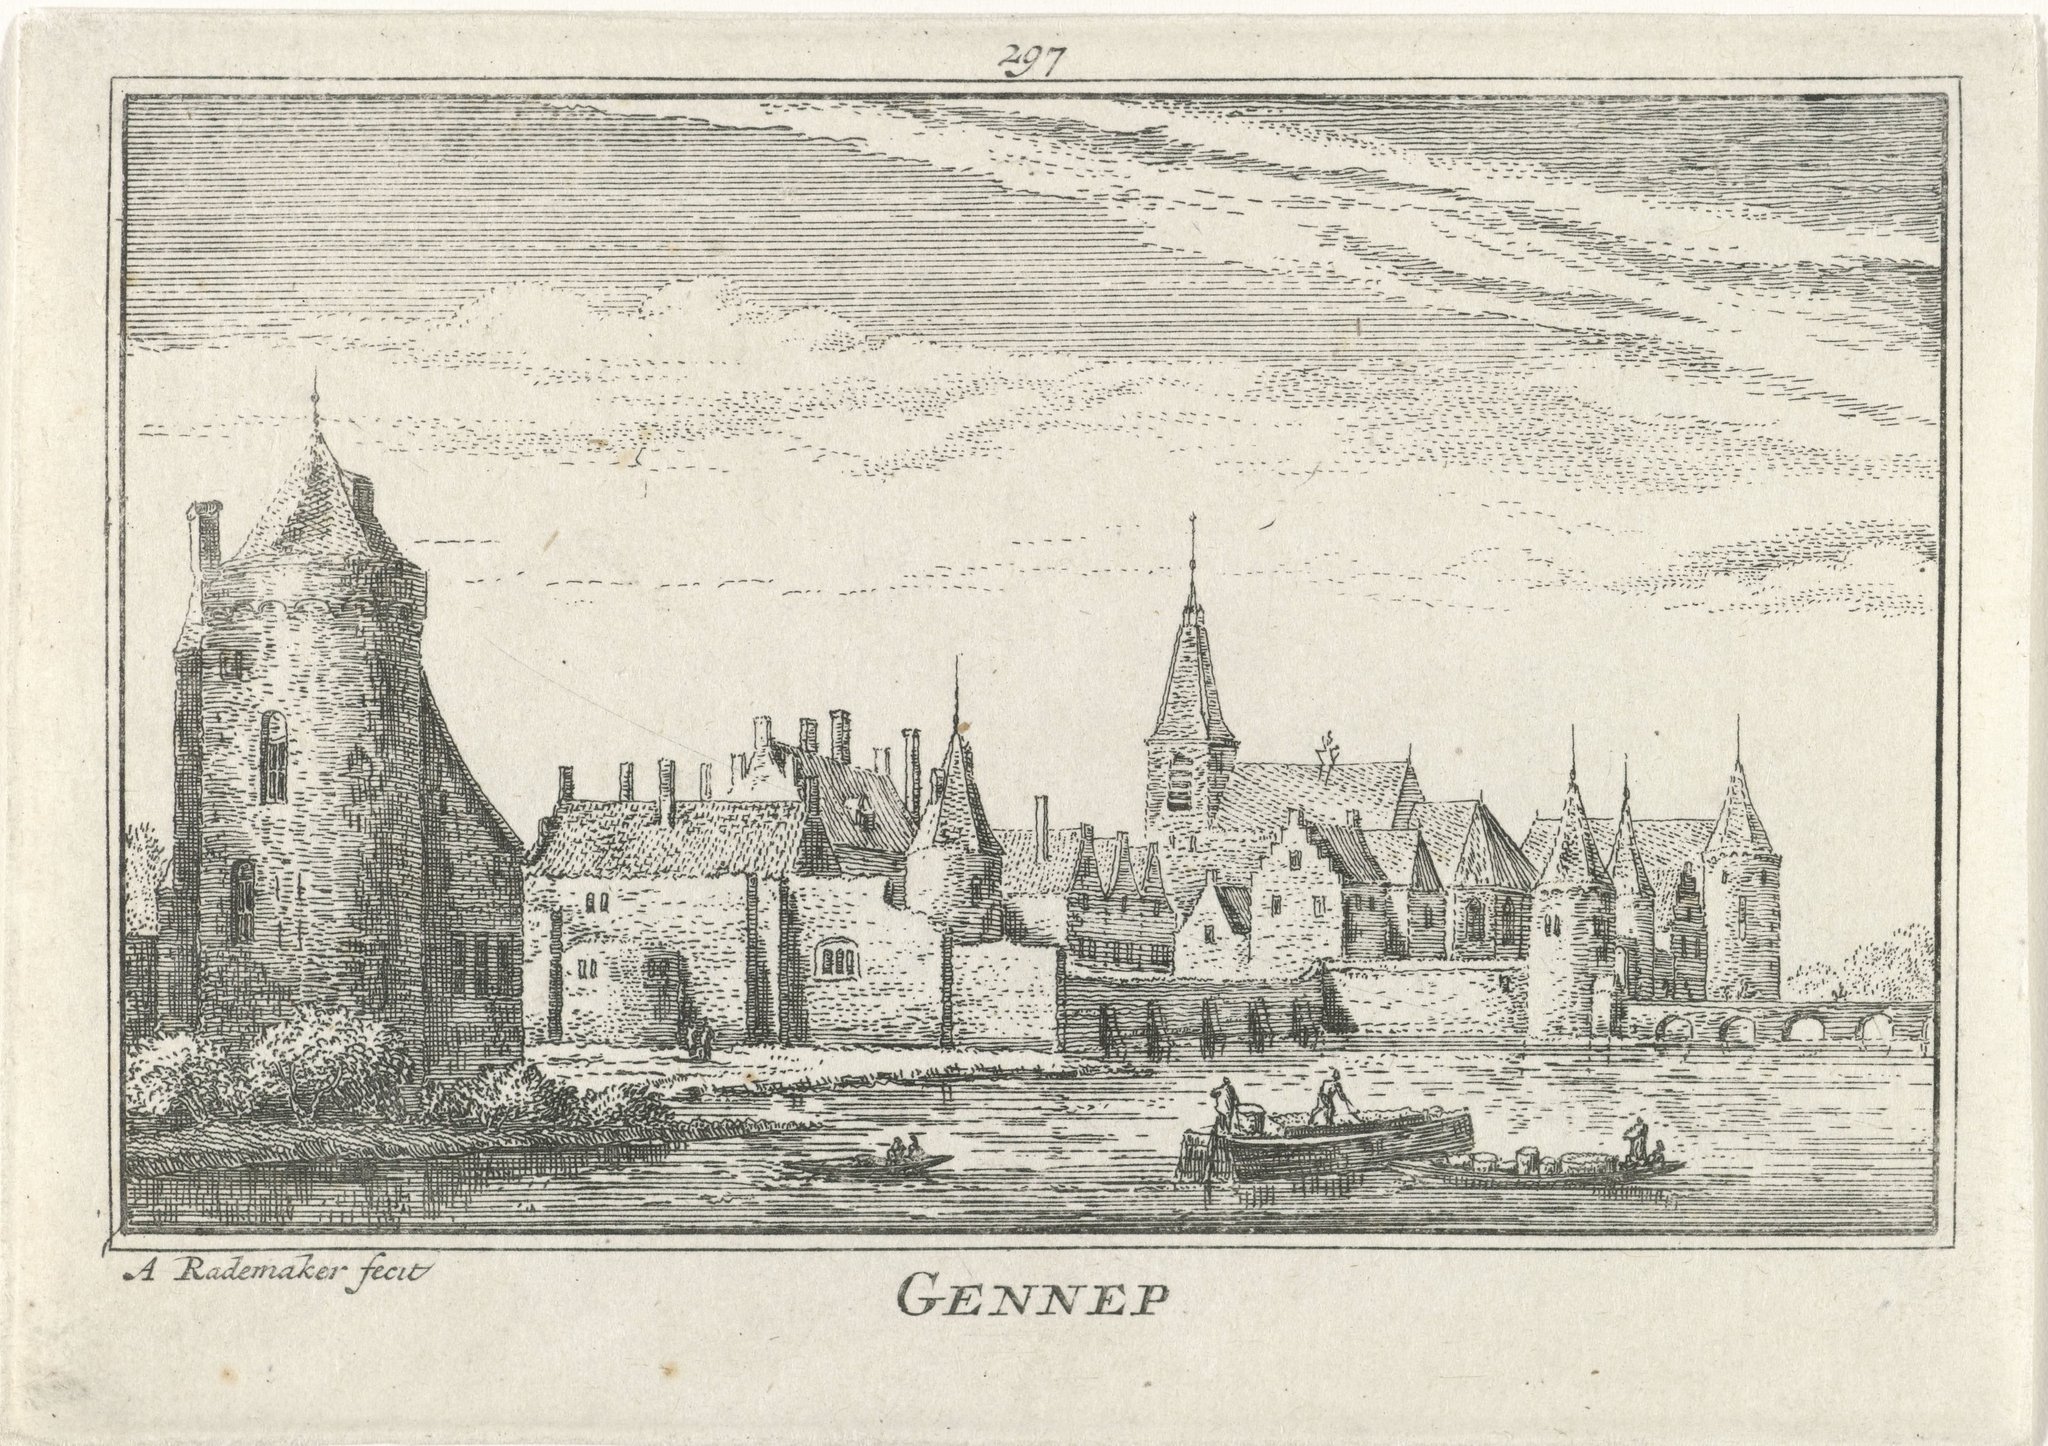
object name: print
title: Gennep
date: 1727-1733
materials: paper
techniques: etching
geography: amsterdam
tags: church (exterior), rowing-boat, canoe, etc.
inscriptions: collector's mark: Lugt 2228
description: Illustratie uit: Abraham Rademaker, Matthaeus Brouërius van Niedek, Isaac Le Long, Kabinet van Nederlandsche en Kleefsche outheden en (...) voorname stads- en landgebouwen, Willem Barents en Antoni Schoonenburg: Amsterdam, 1727-1733, ill. nr. 297.